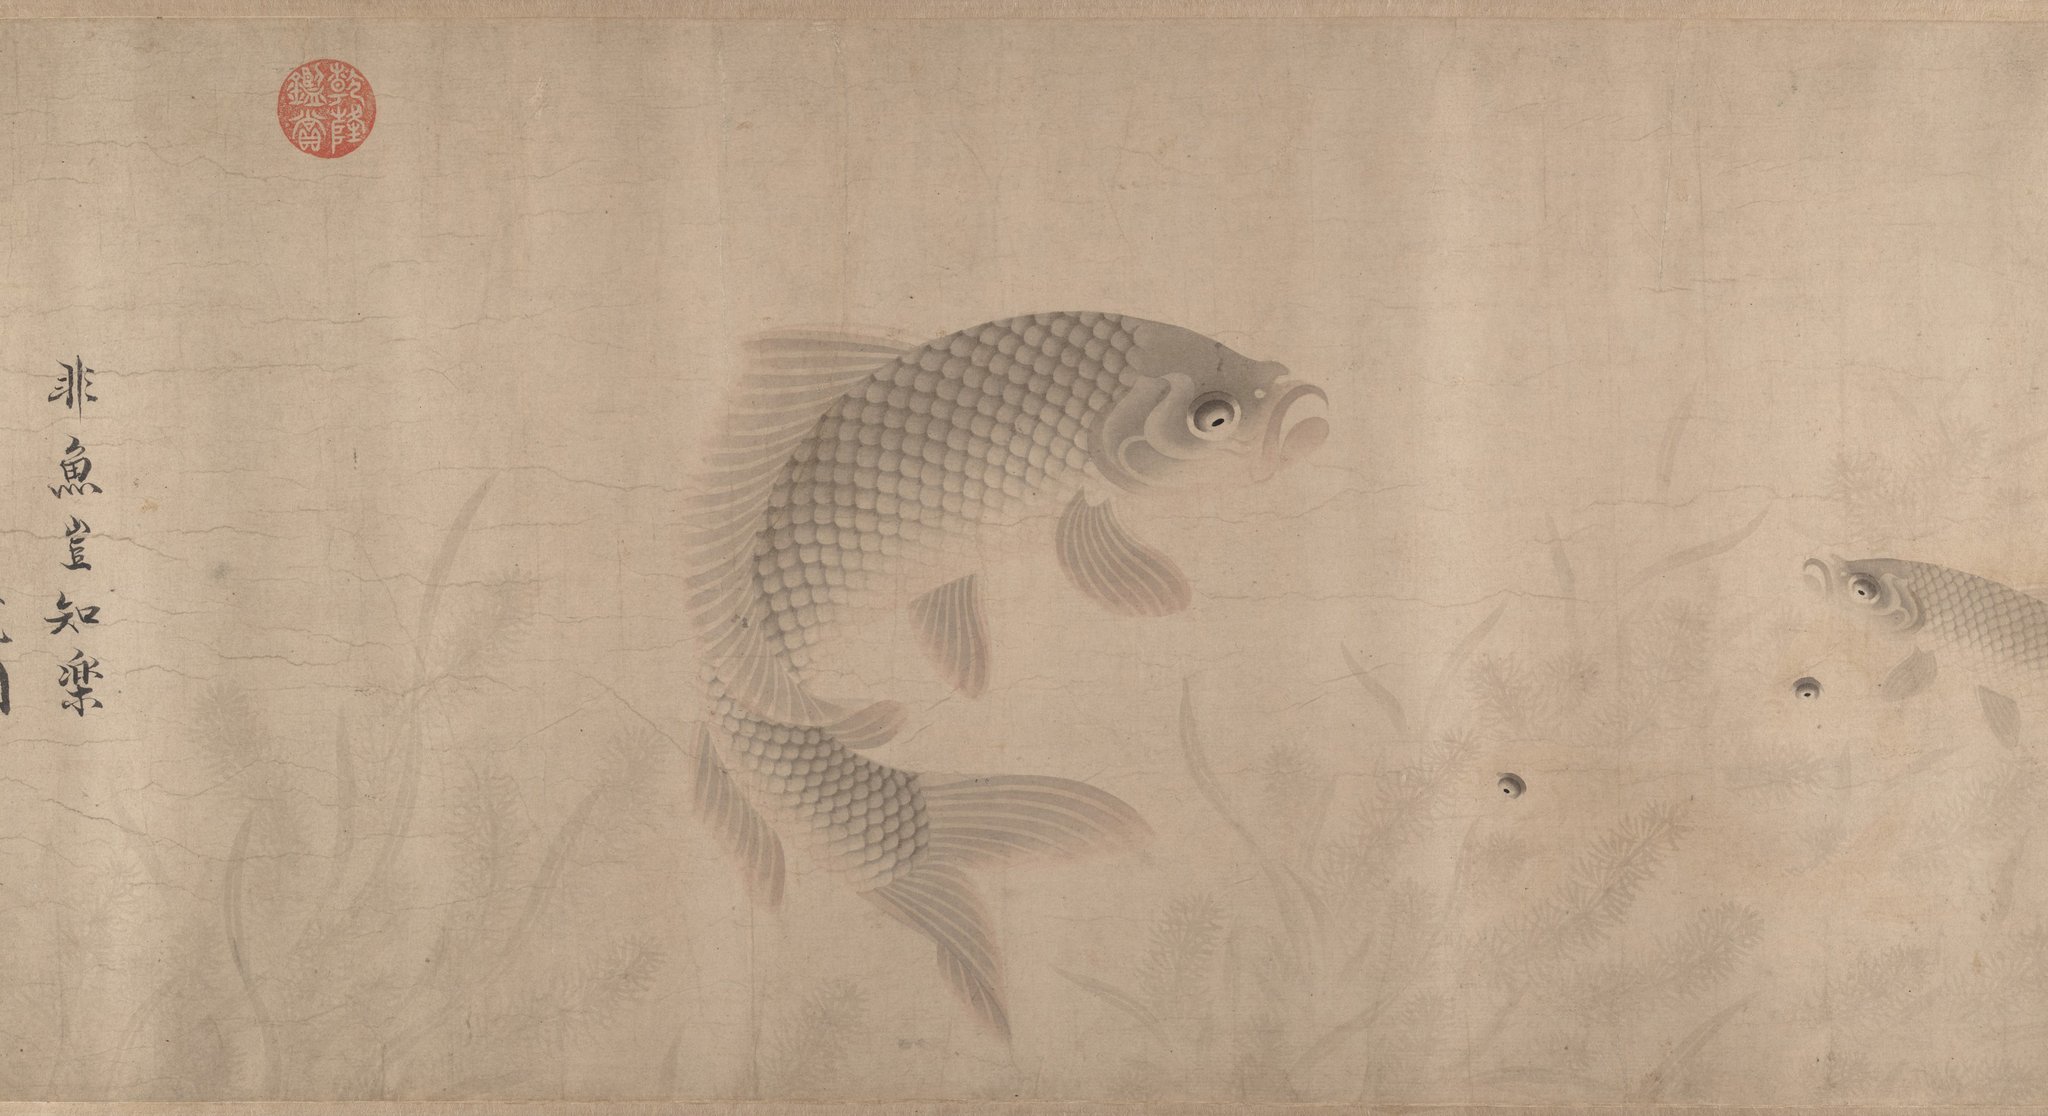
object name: handscroll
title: The Pleasures of Fishes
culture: chinese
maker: zhou dongqing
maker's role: artist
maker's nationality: chinese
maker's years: 13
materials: ink, paper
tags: fish